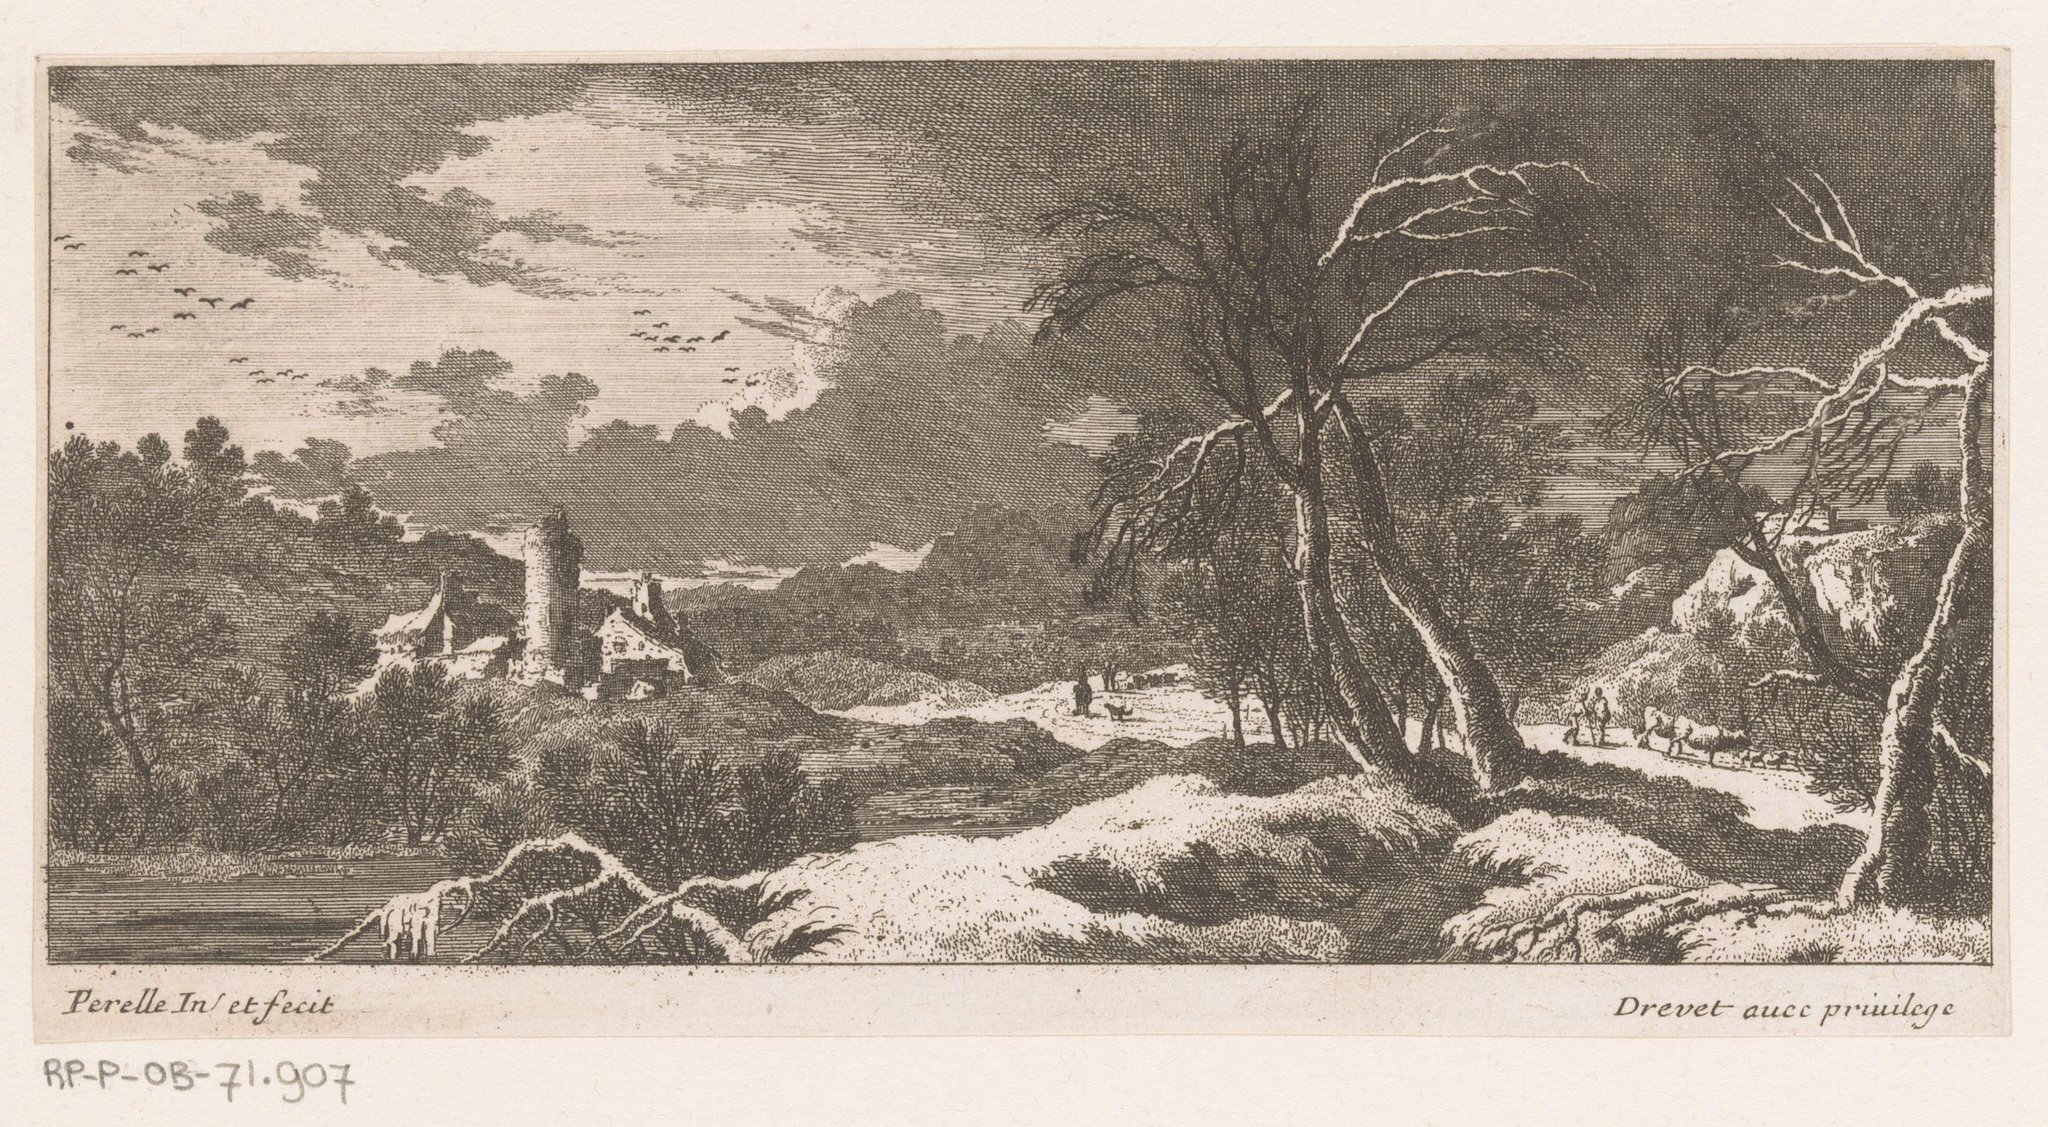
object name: print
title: Winterlandschap met huizen en toren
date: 1673-1695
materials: paper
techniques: etching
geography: paris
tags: landscape with tower or castle, snow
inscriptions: collector's mark: Lugt 240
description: Prenten met het signatuur 'Perelle' kunnen zowel door vader Gabriel als door zonen Nicolas en Adam gemaakt zijn.